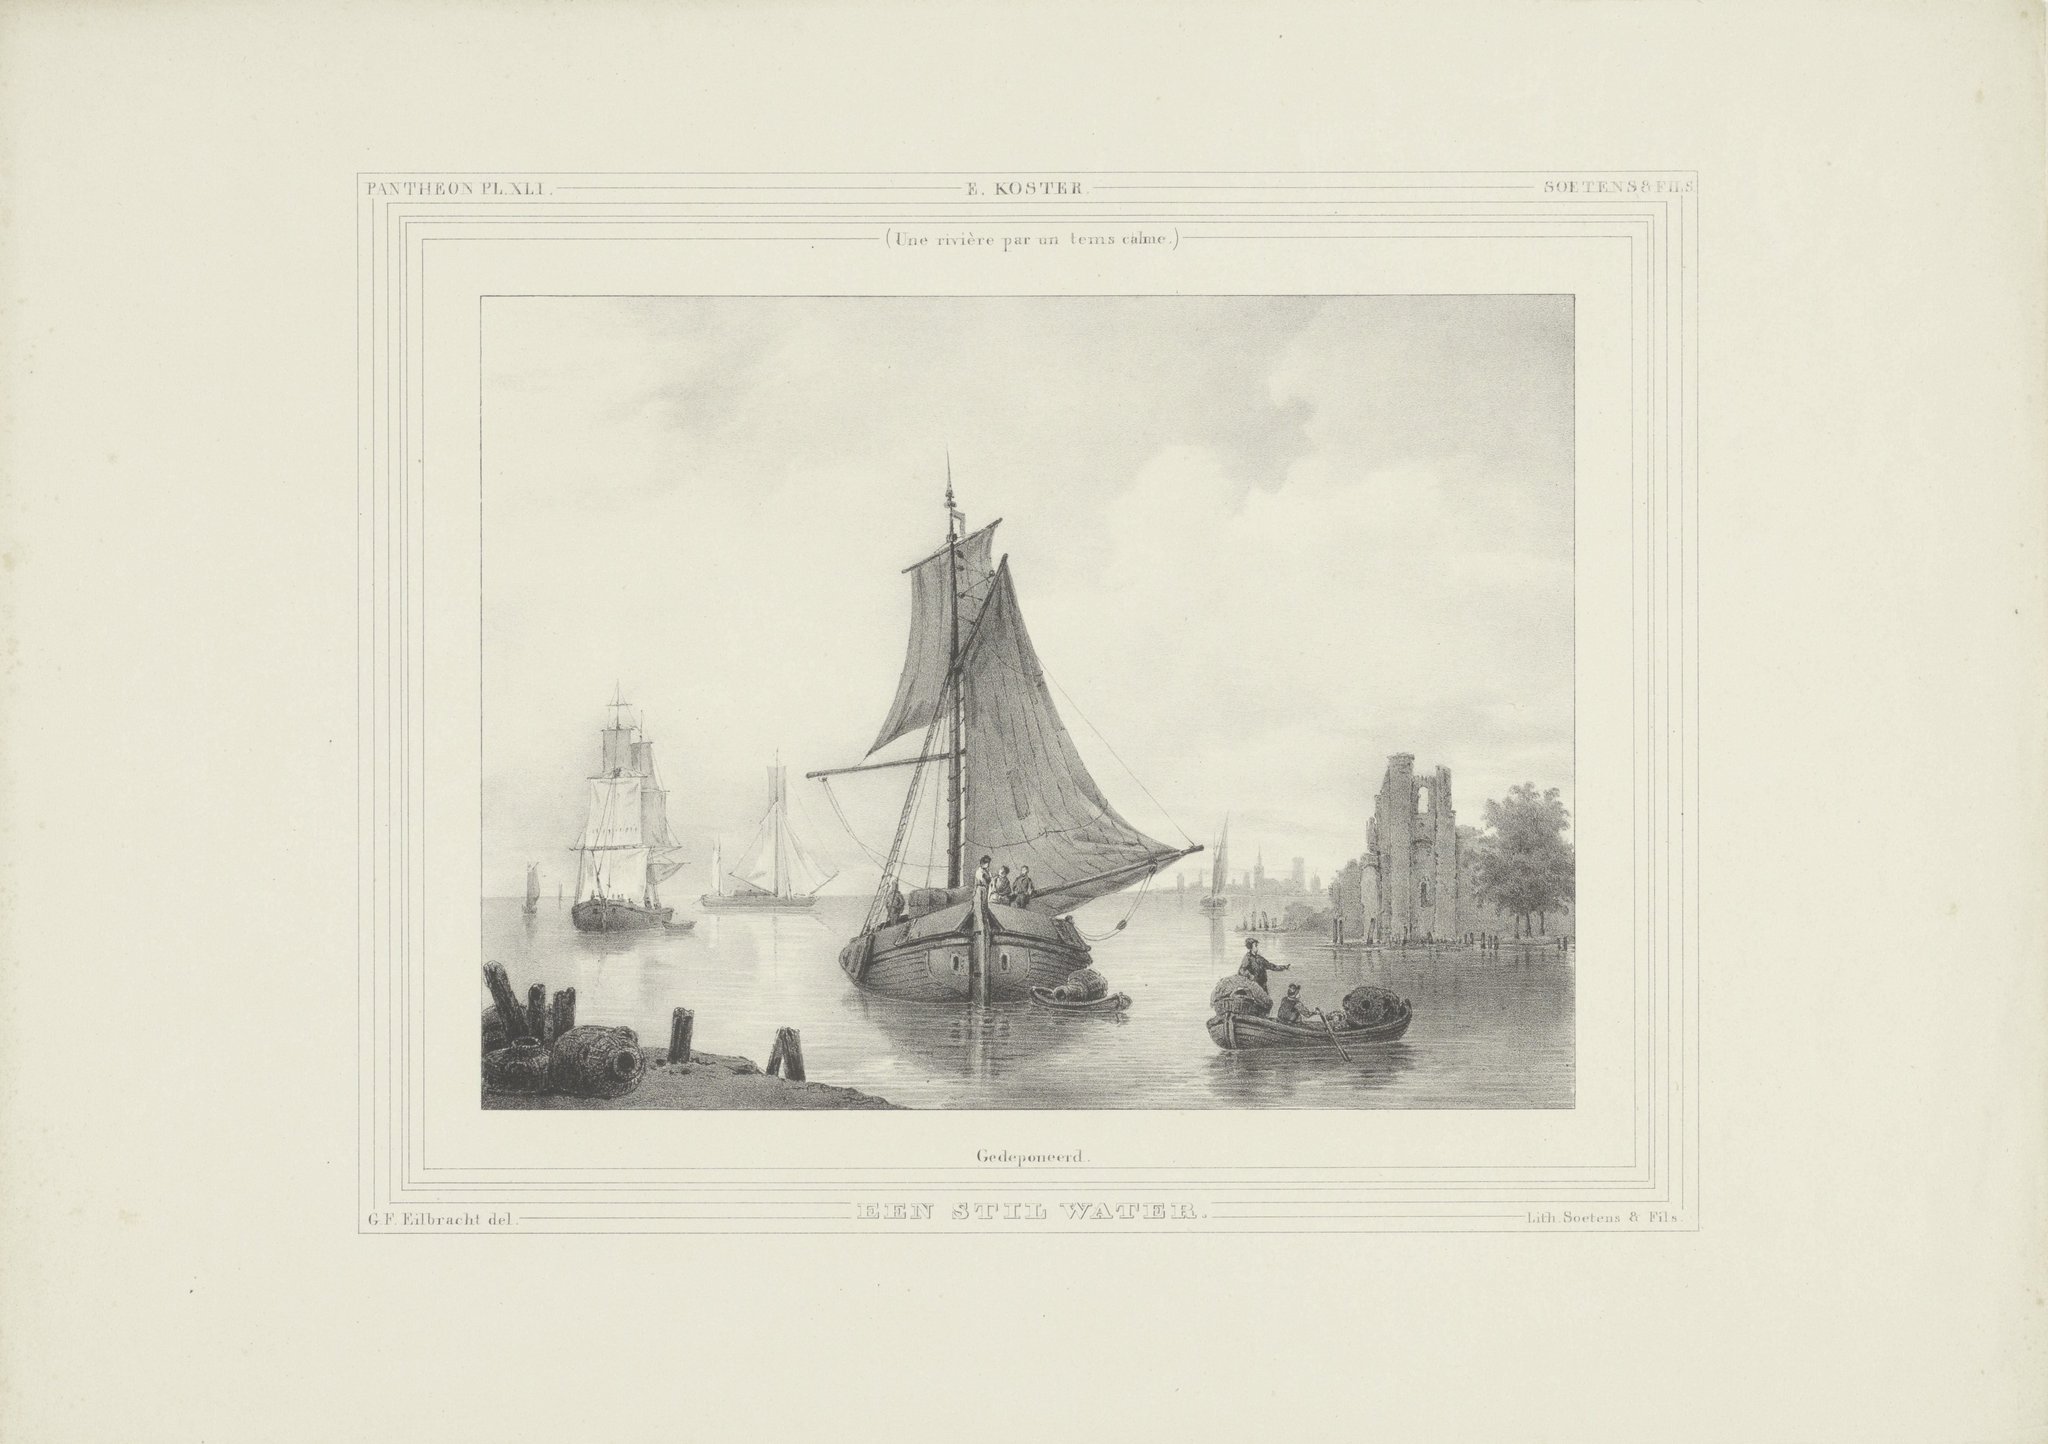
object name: print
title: Een stil water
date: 1837-1840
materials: paper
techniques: lithograph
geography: dordrecht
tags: harbour, sailing-ship, sailing-boat, landscape with ruins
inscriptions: : ‘Gedeponeerd.’, collector's mark: Lugt 2228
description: In het midden op het water ligt een zeilschip met gestreken zeilen en bemanning aan boord. Verderop liggen nog twee zeilschepen. Vooraan ligt een kleine roeiboot met twee figuren. Rechts een boom en een ruïne. Genummerd linksboven: PANTHEON PL. XLI.